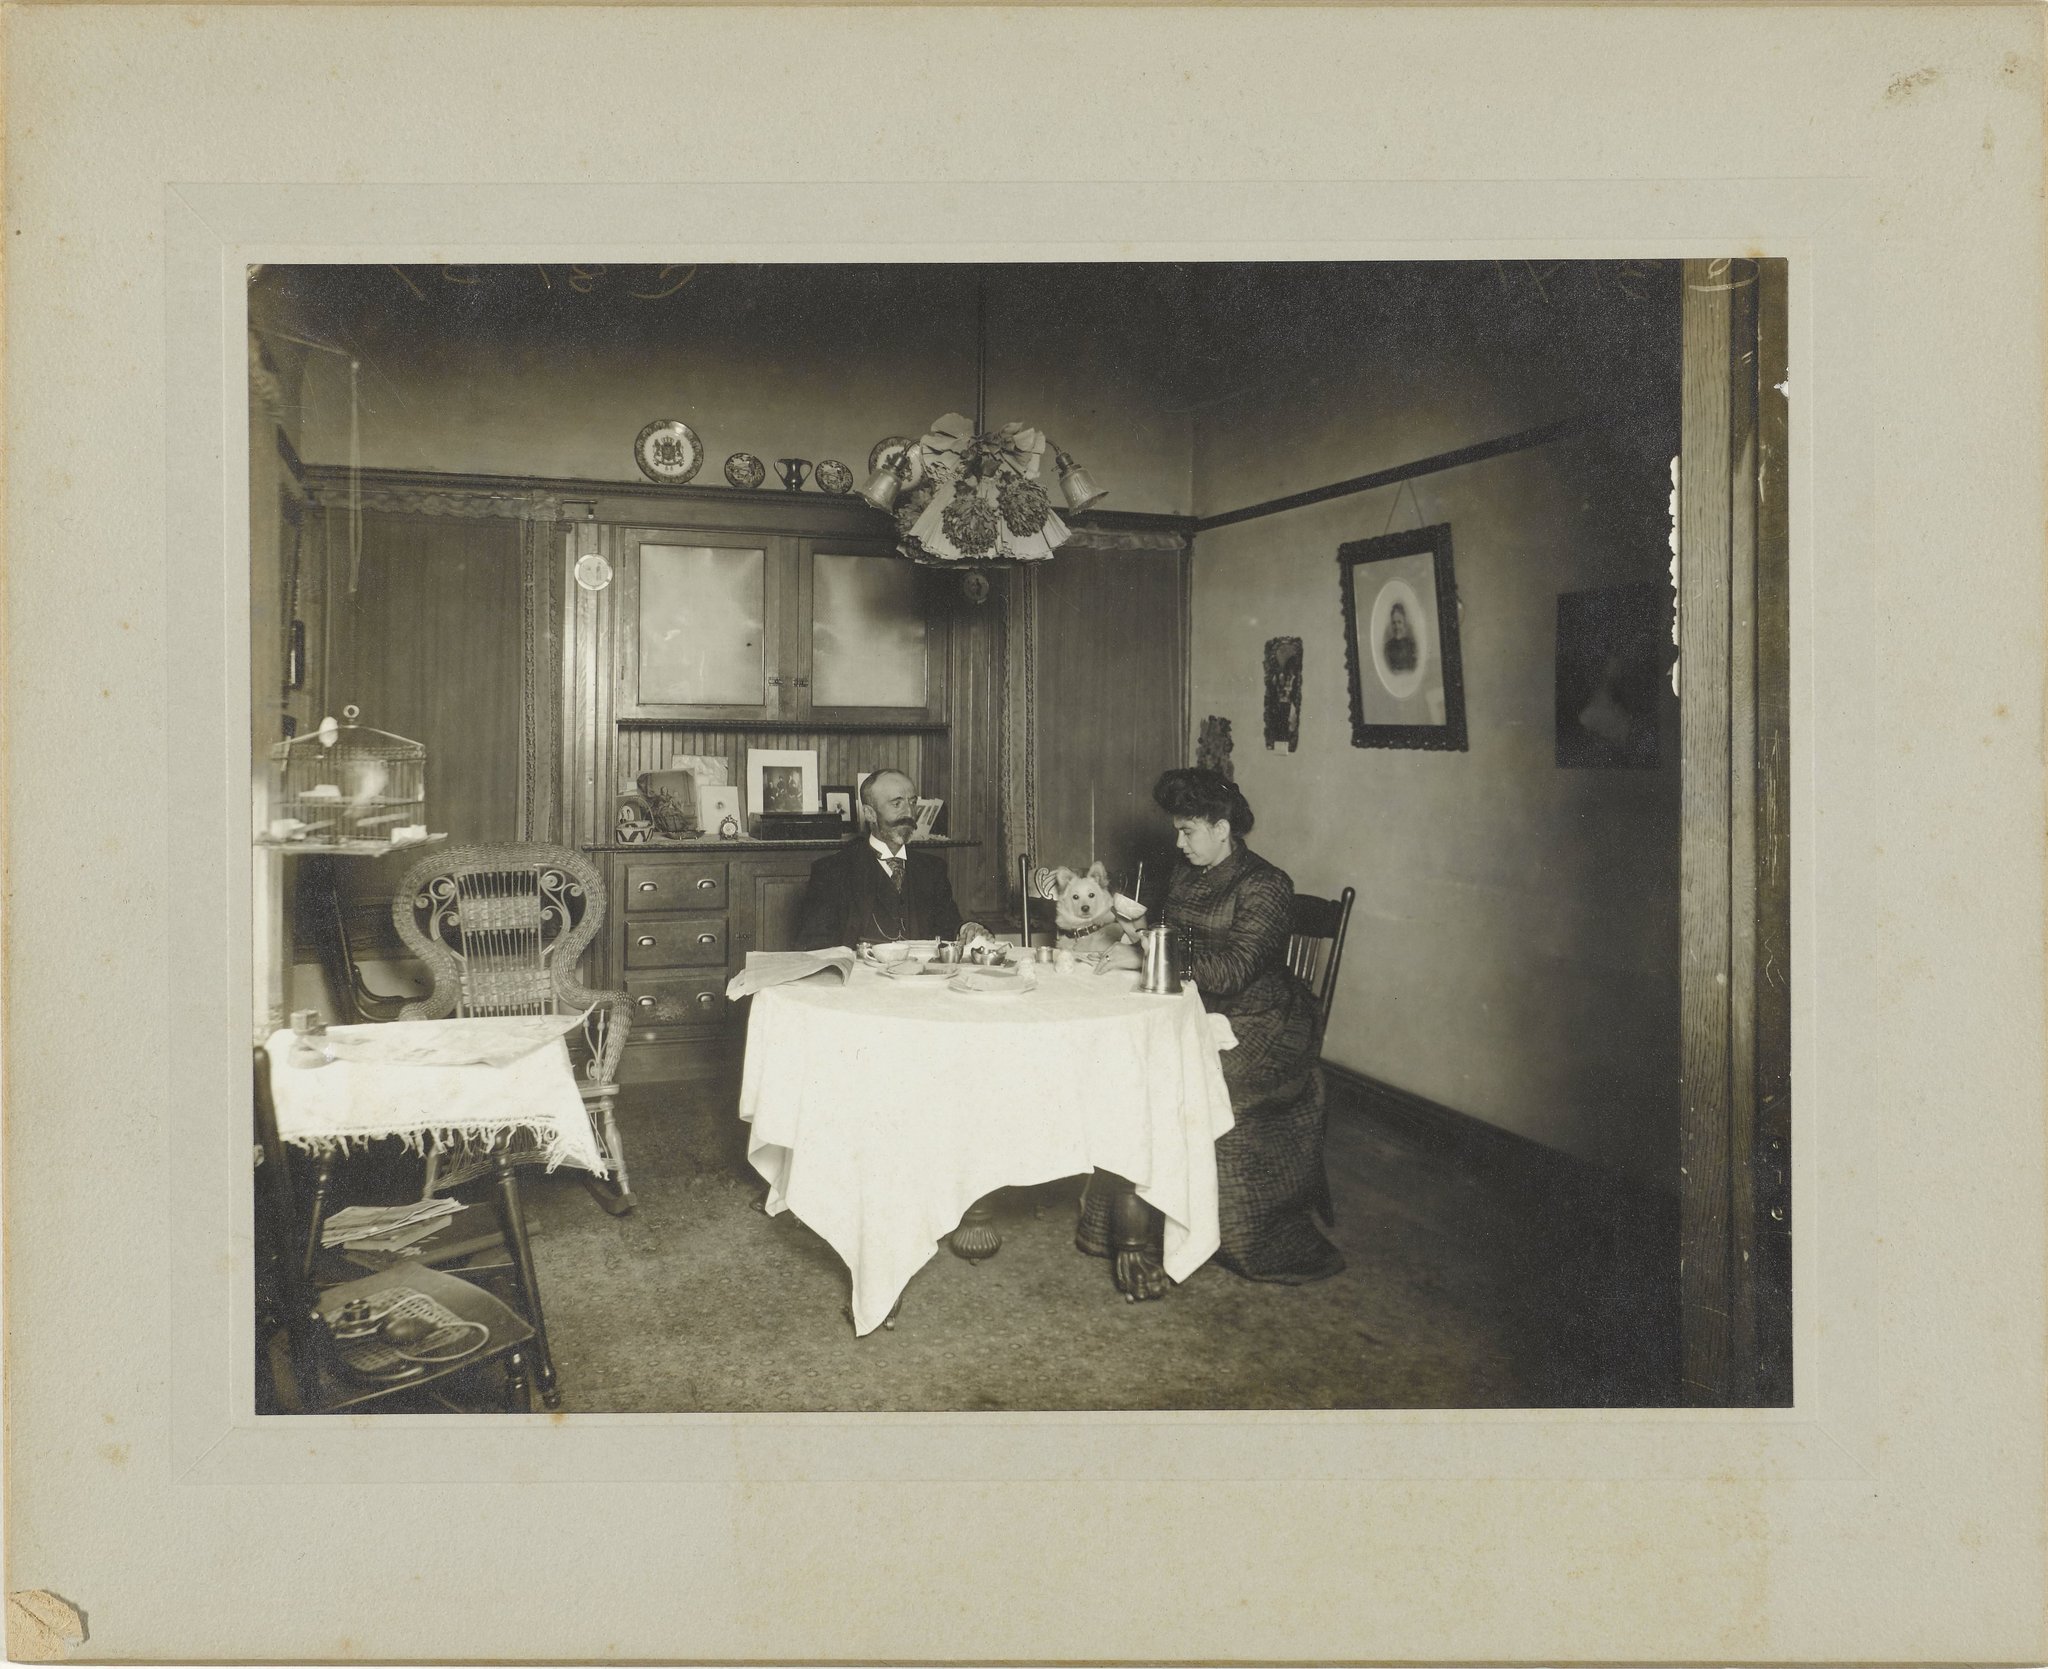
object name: photograph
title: Man en vrouw met hond aan tafel in interieur in Los Angeles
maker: Anonymous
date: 1908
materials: paper, cardboard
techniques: gelatin silver print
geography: los angeles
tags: family life at home, anonymous historical persons portrayed in a double portrait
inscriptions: inscription: ‘31 dec. 1908/ Los Angeles/ cal.’, inscription: ‘anon vgl Bushnelf [?]’